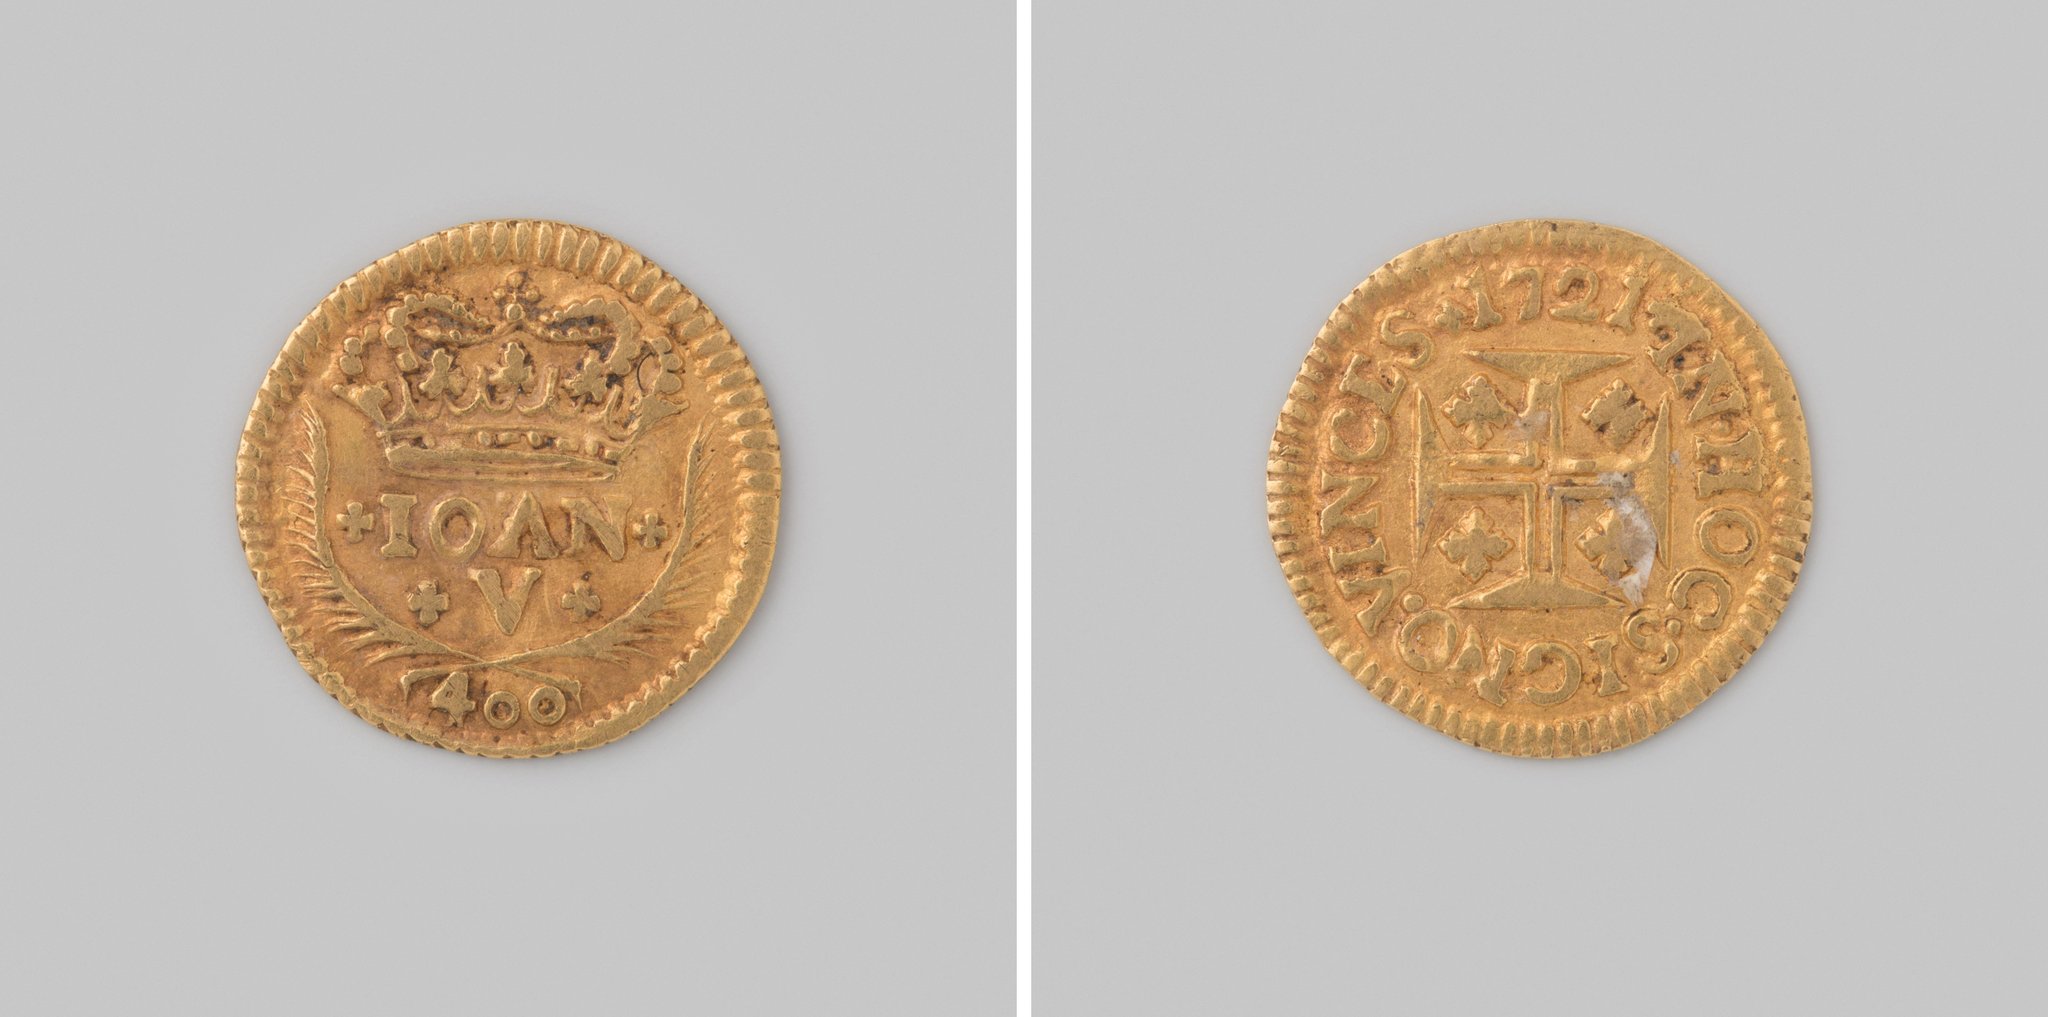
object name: coin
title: Portugal, koning Joao V, cruzado of 400 reis, 1721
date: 1721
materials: gold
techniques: striking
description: Gouden munt. Voorzijde: tussen twee gekruiste takken kroon, waaronder in twee regels naam van de koning. Onderaan waarde-aanduiding: 400. Keerzijde: kort gevoet kruis, met in de hoeken kruisjes. Jaartal bovenaan in omschrift. Kabelrand.